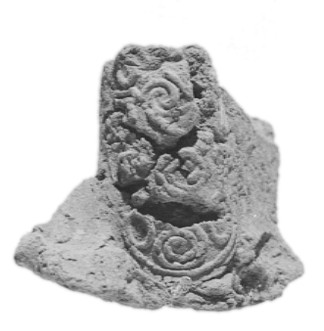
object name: sealing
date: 2030-1640 BCE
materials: clay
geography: egypt